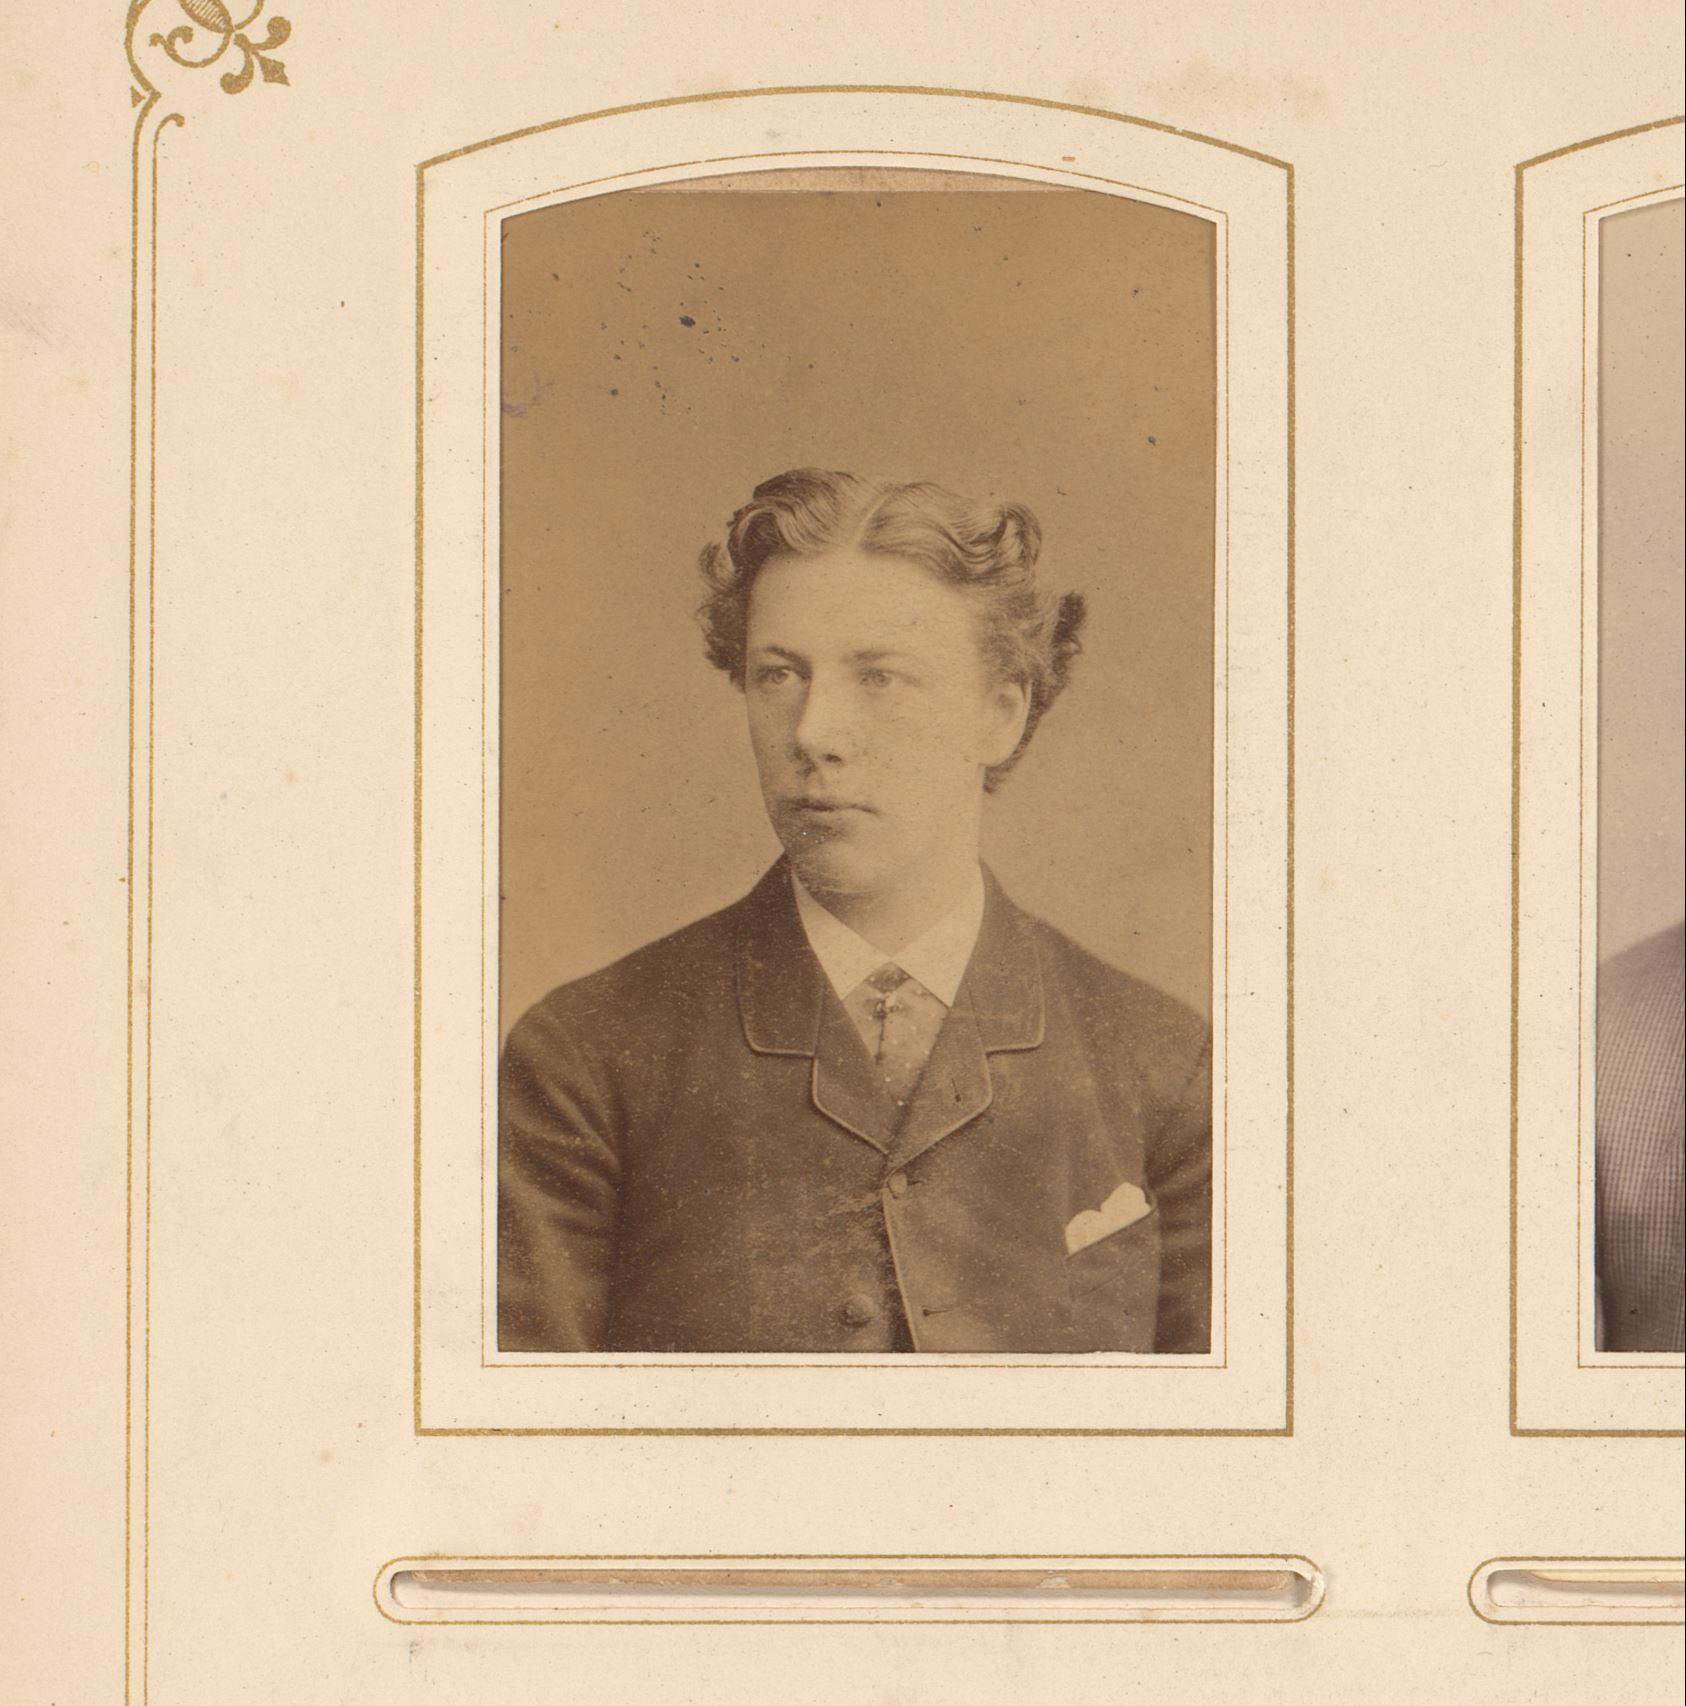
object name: photograph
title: Portret van een jonge man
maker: julius jr. ortgies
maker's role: fotograaf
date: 1850-1900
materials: cardboard, photographic support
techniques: albumen print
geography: bremen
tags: historical persons, youth, adolescent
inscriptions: inscription: ‘Julius Ortgies Jr./ BREMEN/ Photographisches Atelier/ 116. am Wall 116/ früher Wall 160/ zwischen d. Ansgarii u. Heerdenthor./ Zu Nabestellungen wird die Originalplatte aufbewahrt.’, : ‘Osc. Schütze/ Mathildenstr. 77/ Bremen’